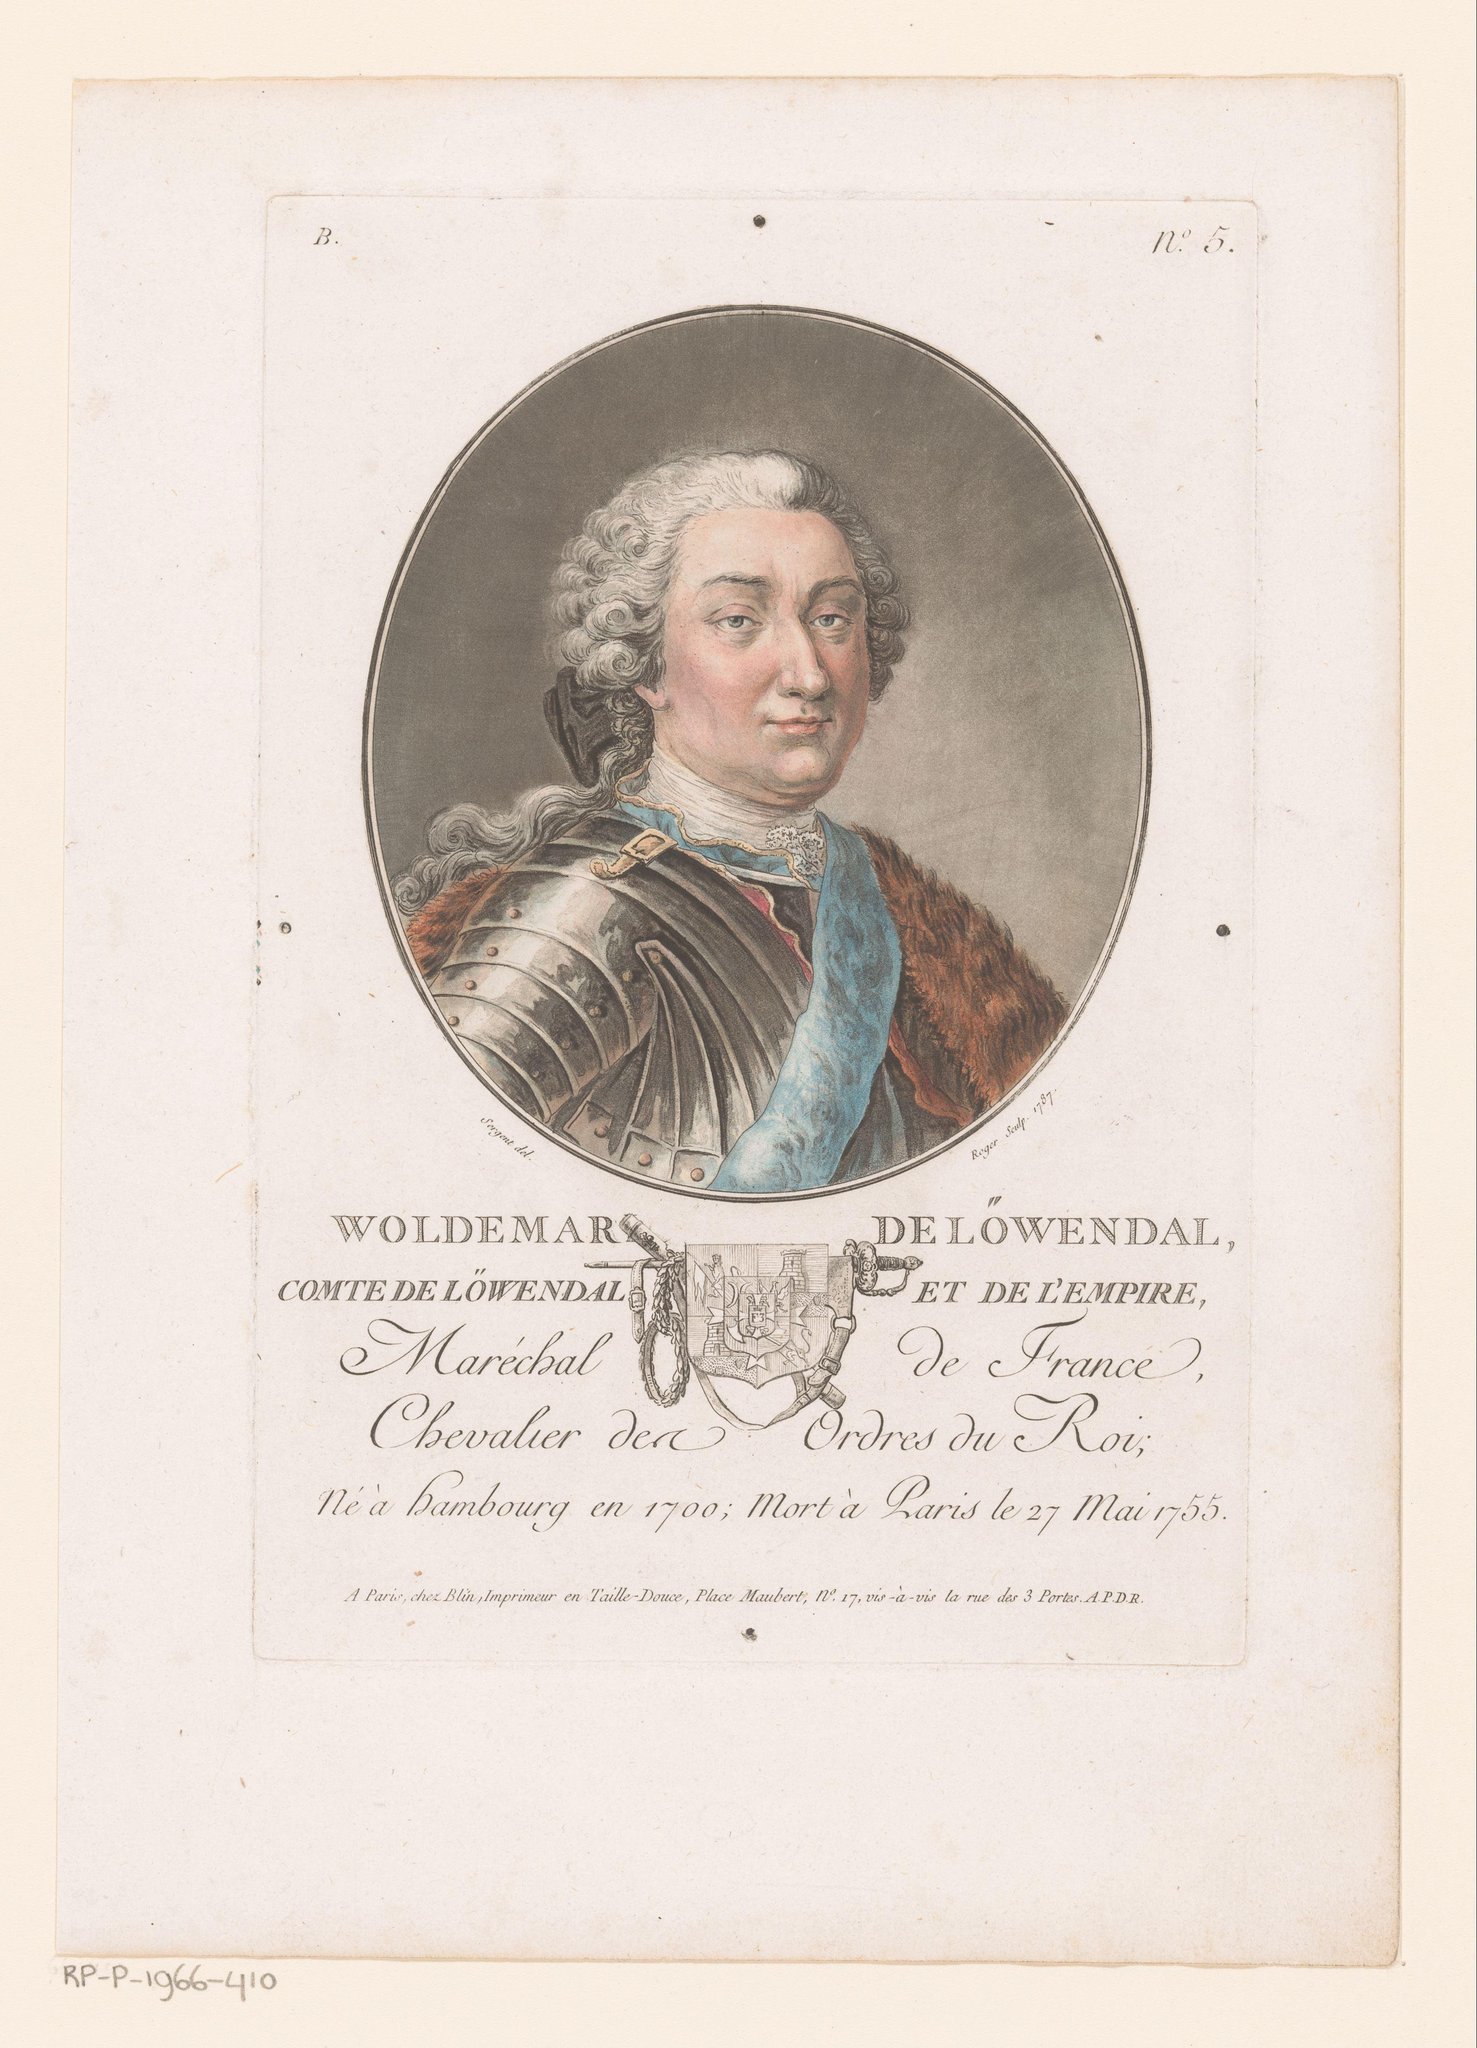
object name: print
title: Portretten van Franse beroemdheden en Franse gedenkwaardige gebeurtenissen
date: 1787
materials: paper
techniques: aquatint, etching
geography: paris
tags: ranks in the army, historical persons, nobility and patriciate; chivalry, knighthood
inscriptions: collector's mark: Lugt 2228